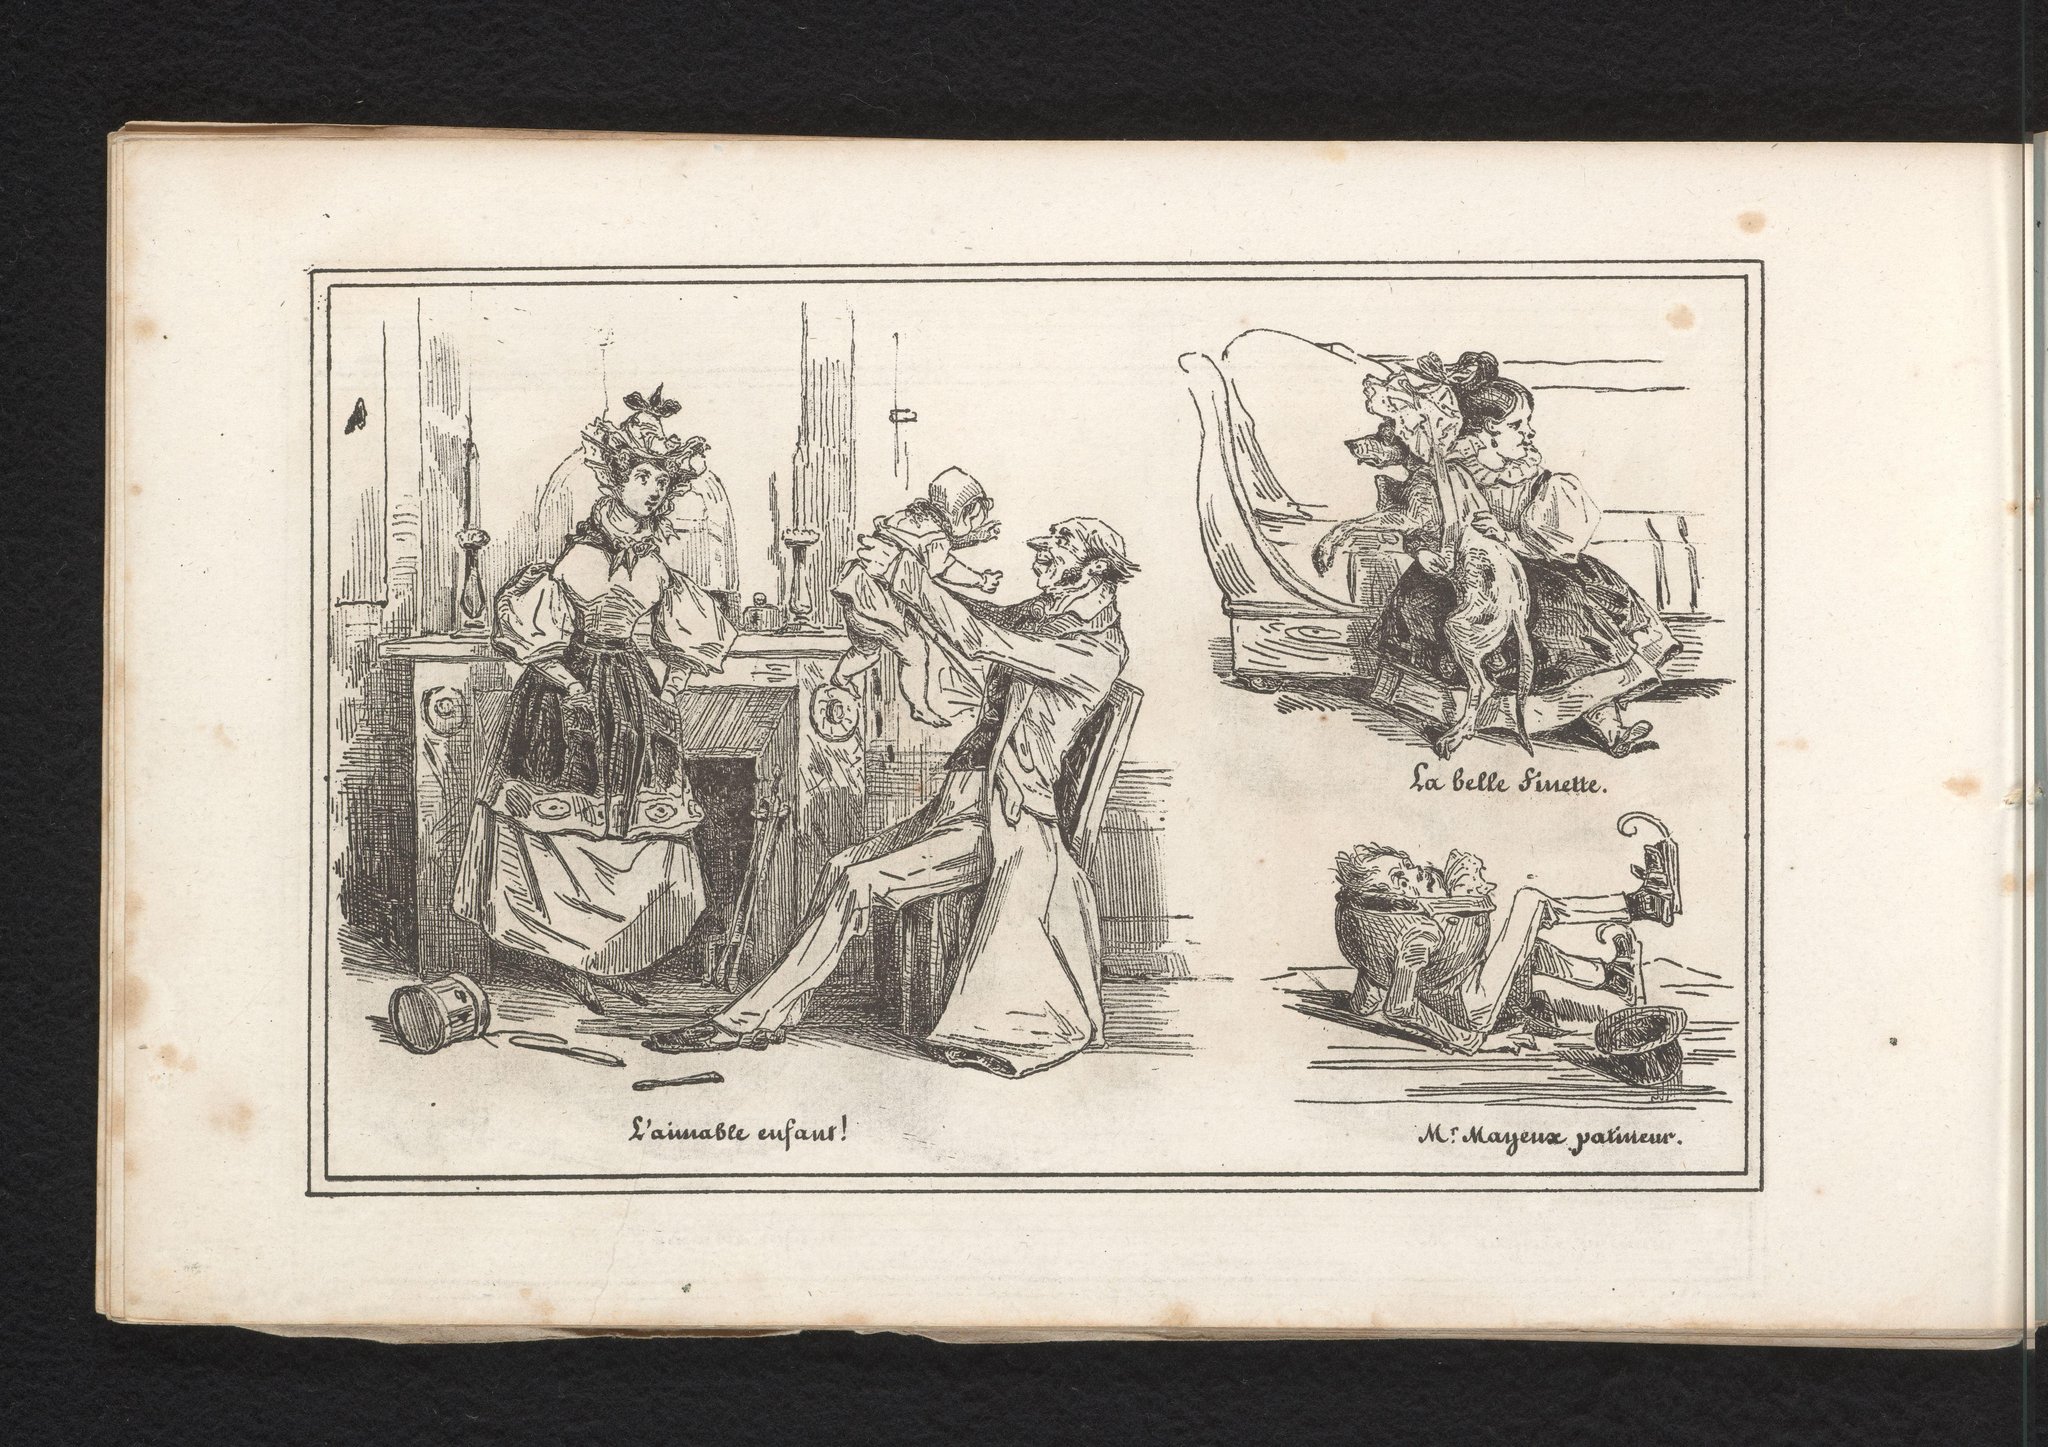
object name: print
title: La belle Finette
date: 1834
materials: paper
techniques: engraving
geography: paris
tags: family, descendance, skates (winter sports) (+ accident (in sports, games, etc.)), dog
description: Blad met drie afzonderlijke voorstellingen. Deze prent maakt deel uit van een album.